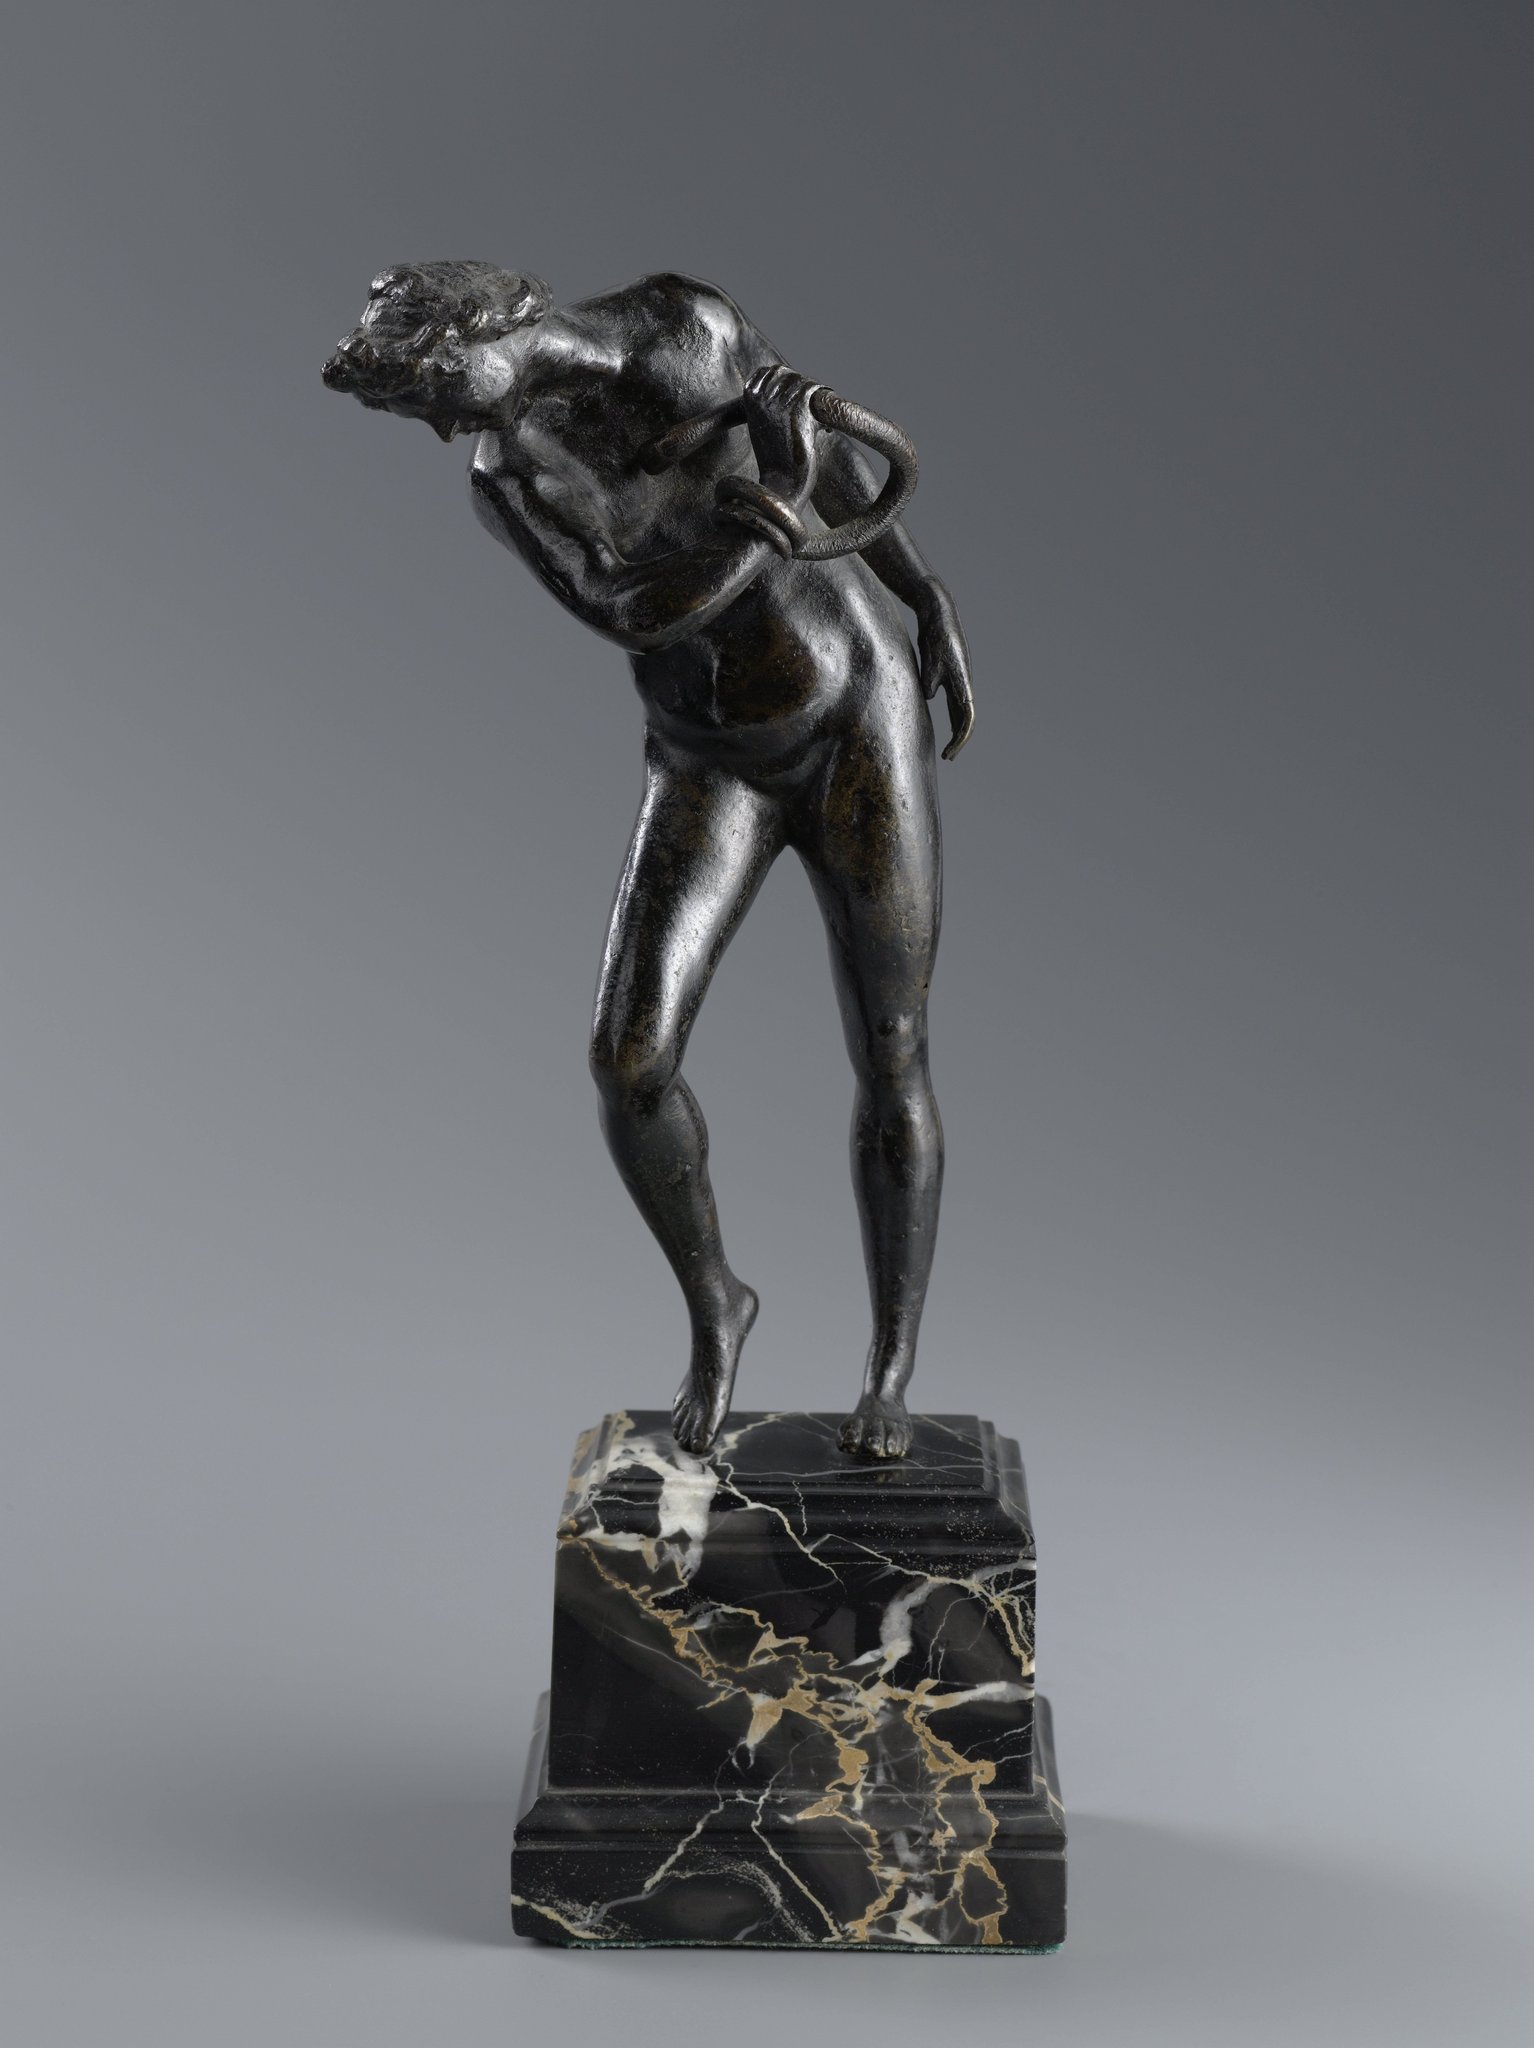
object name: inkwell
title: Cleopatra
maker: benvenuto cellini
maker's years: 1500-1571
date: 1500-1599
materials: bronze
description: Circle of Benvenuto Cellini (1500 - 1572). Cleopatra. Bronze. Florence, c. 1550.